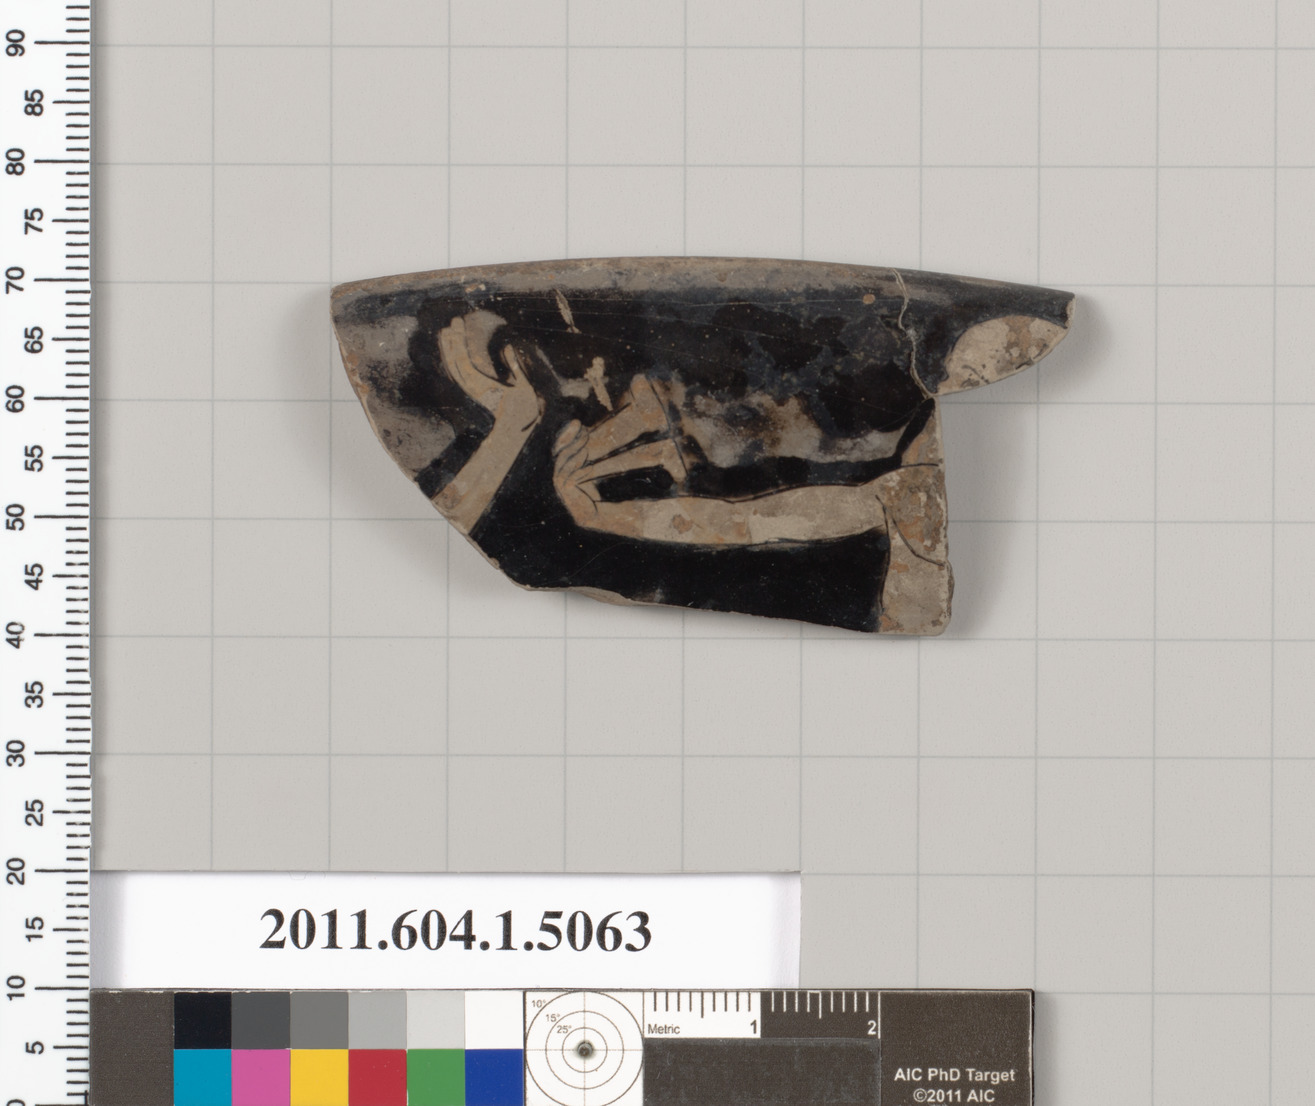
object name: kylix fragment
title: Terracotta rim fragment of a kylix (drinking cup)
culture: greek, attic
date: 500-470 BCE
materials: terracotta